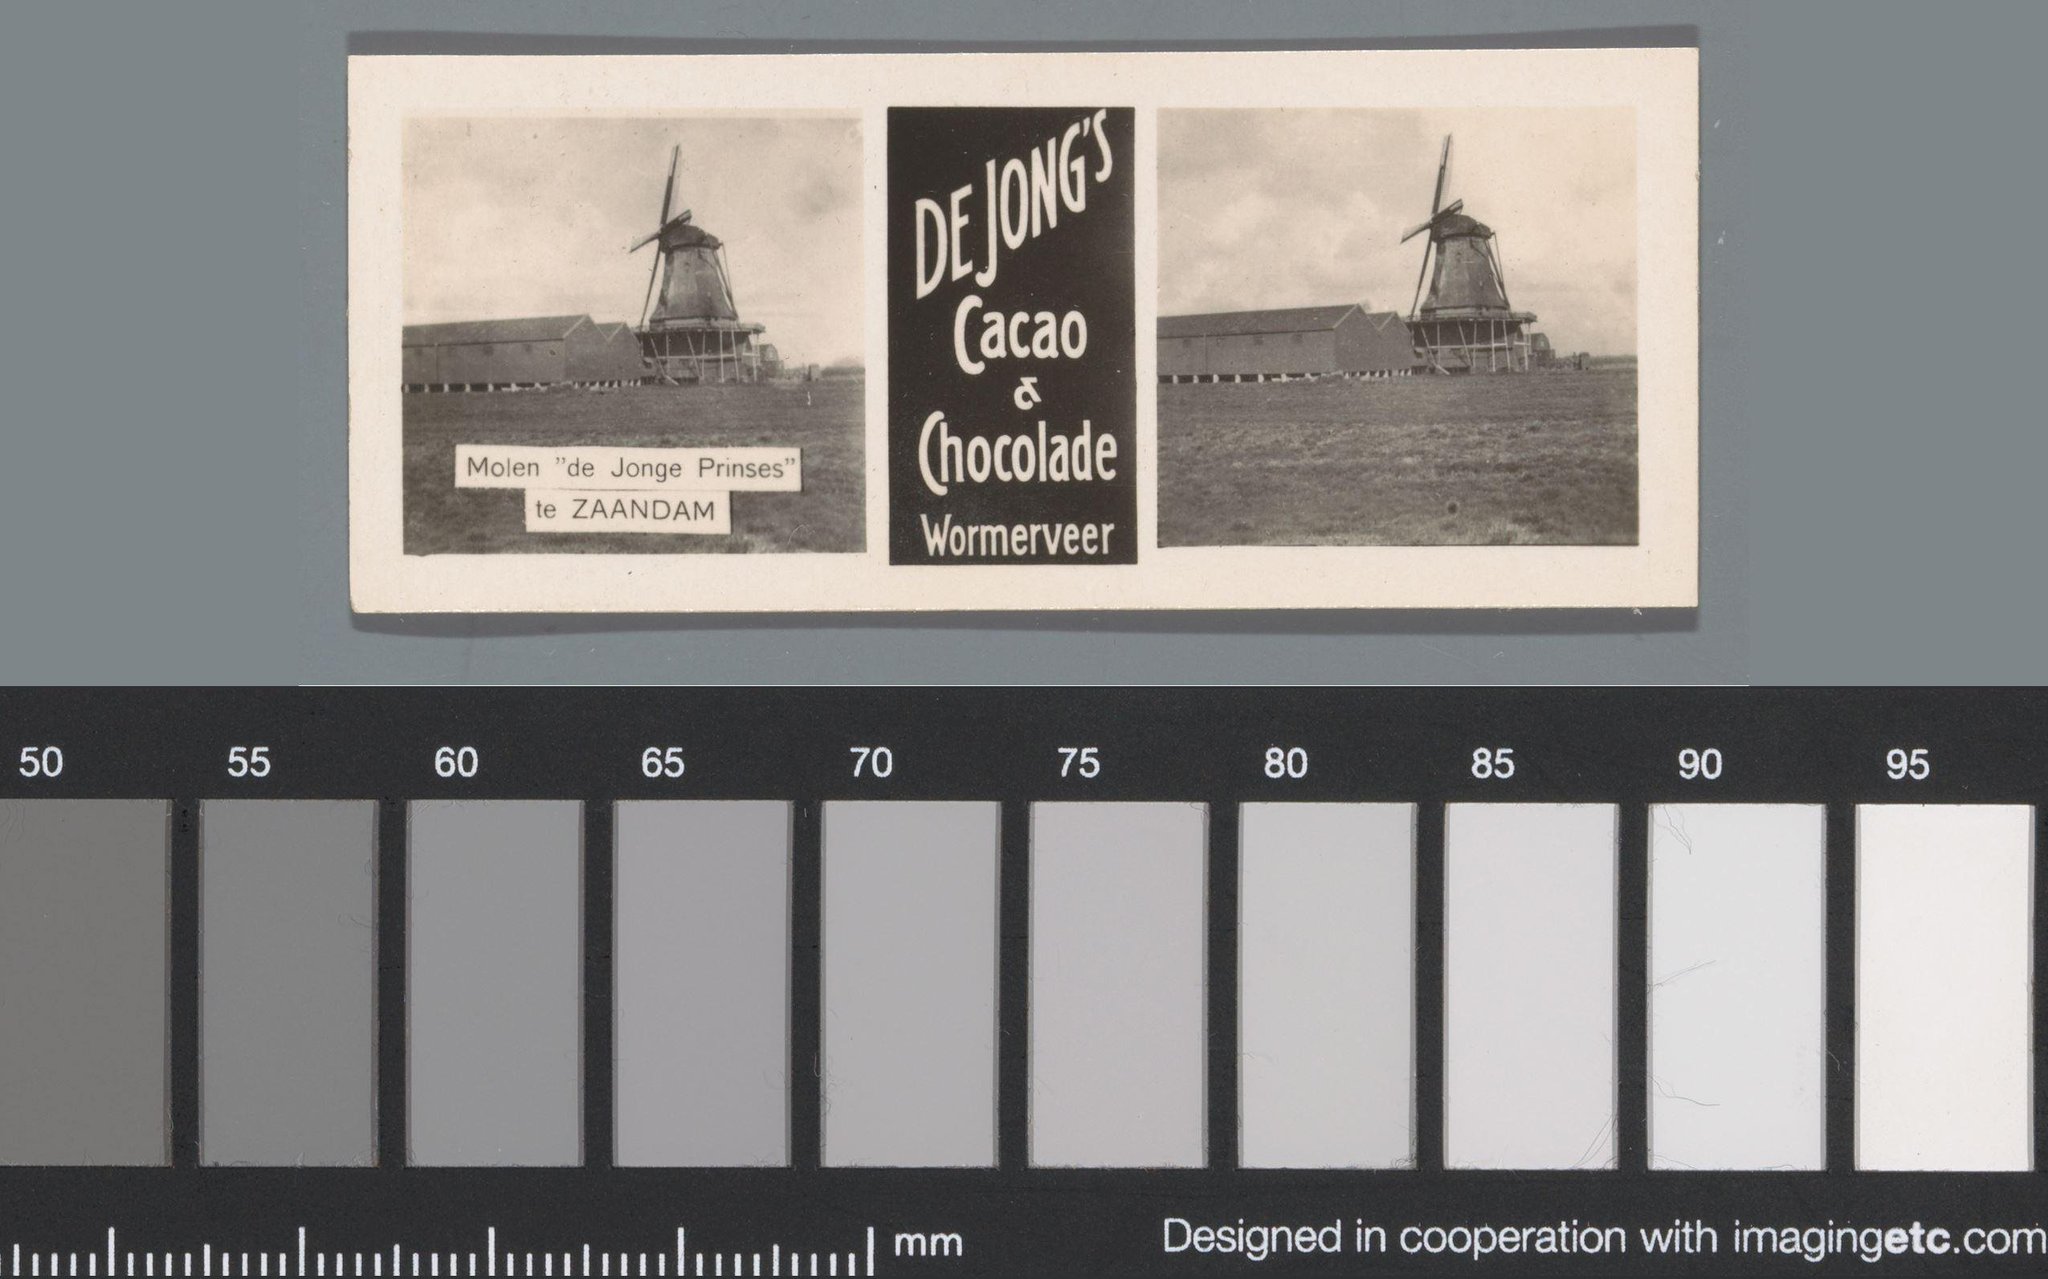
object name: stereograph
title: Gezicht op de molen De Jonge Prinses te Zaandam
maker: Anonymous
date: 1900-1910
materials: cardboard, photographic support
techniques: gelatin silver print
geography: zaandam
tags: windmill in landscape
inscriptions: inscription: ‘De Jong's Caceo & Chocolade Wormerveer’, inscription: ‘Stereoscoopjes (...) De Jong te Wormerveer.’